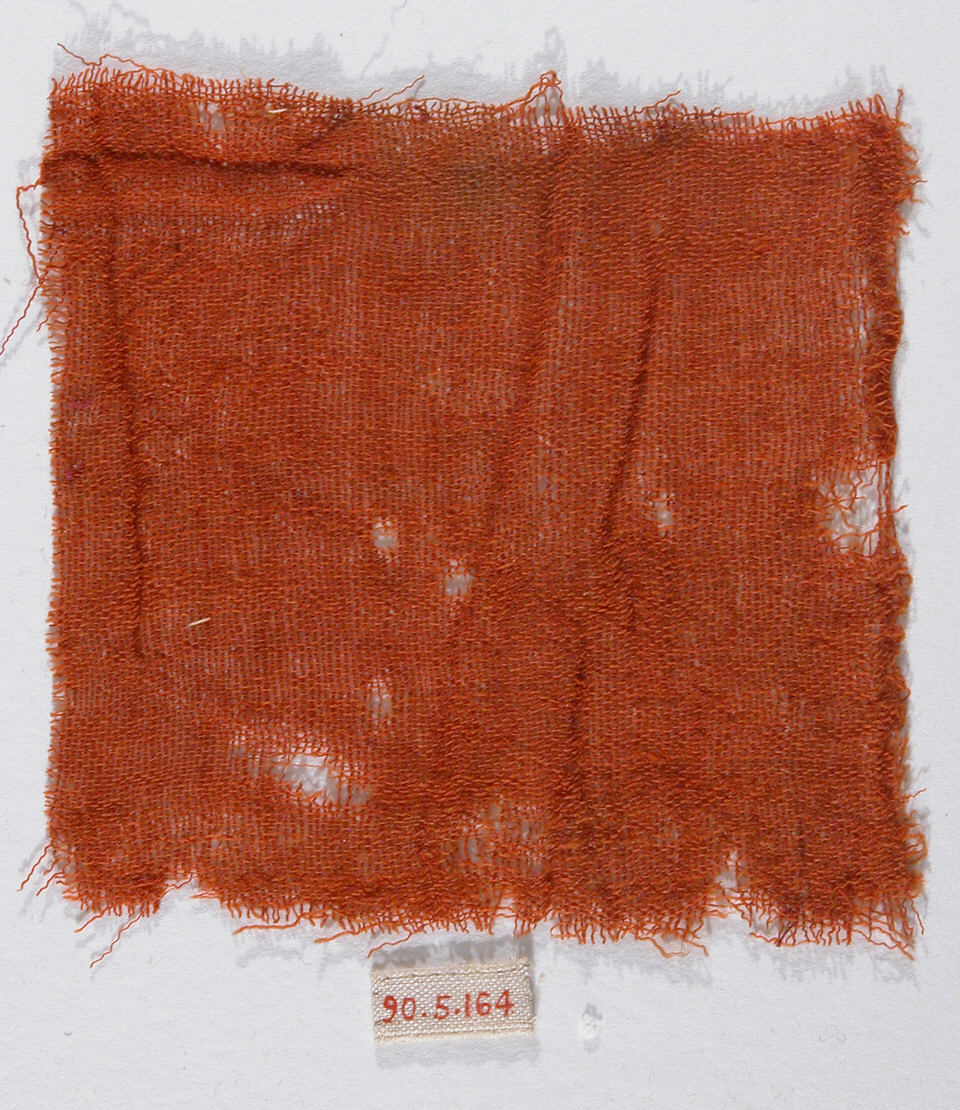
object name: textile fragment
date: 100 BCE-100 CE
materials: linen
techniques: weave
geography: egypt